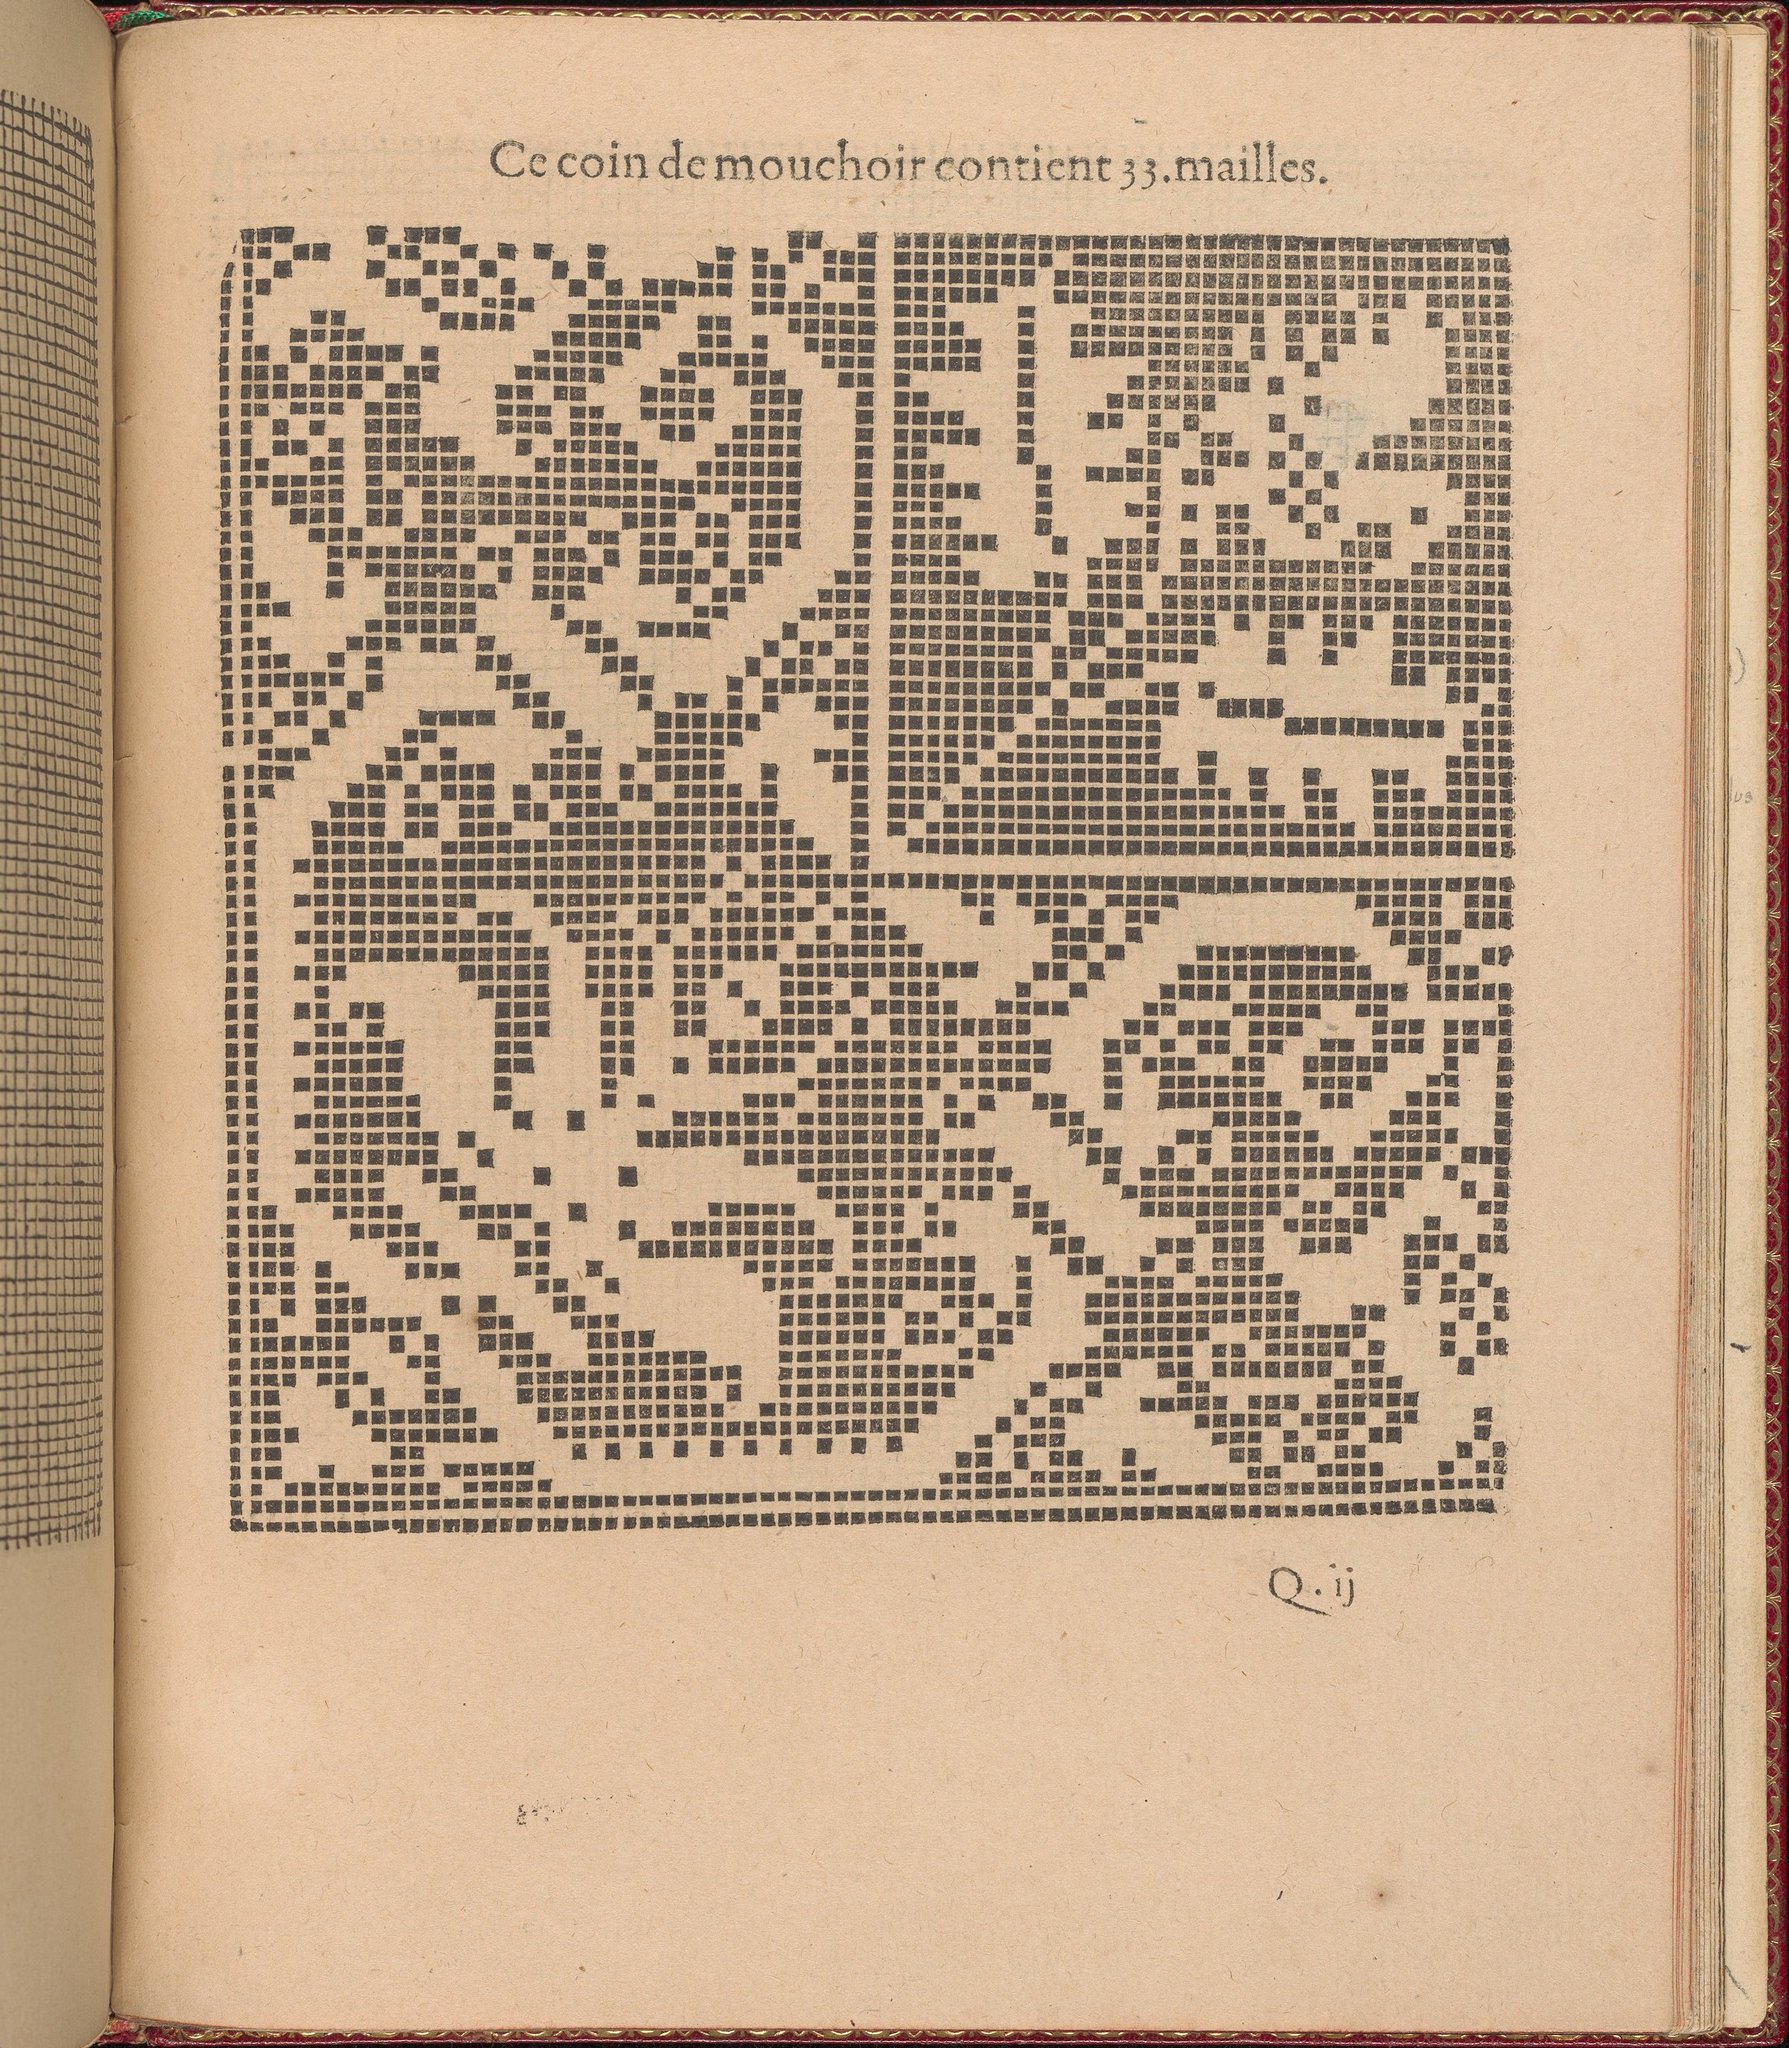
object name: book print ornament architecture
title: Les Singuliers et Nouveaux Portraicts... page 62 (recto)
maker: federico de vinciolo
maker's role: designer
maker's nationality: italian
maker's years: 1582-1599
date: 1588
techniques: woodcut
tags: ornament